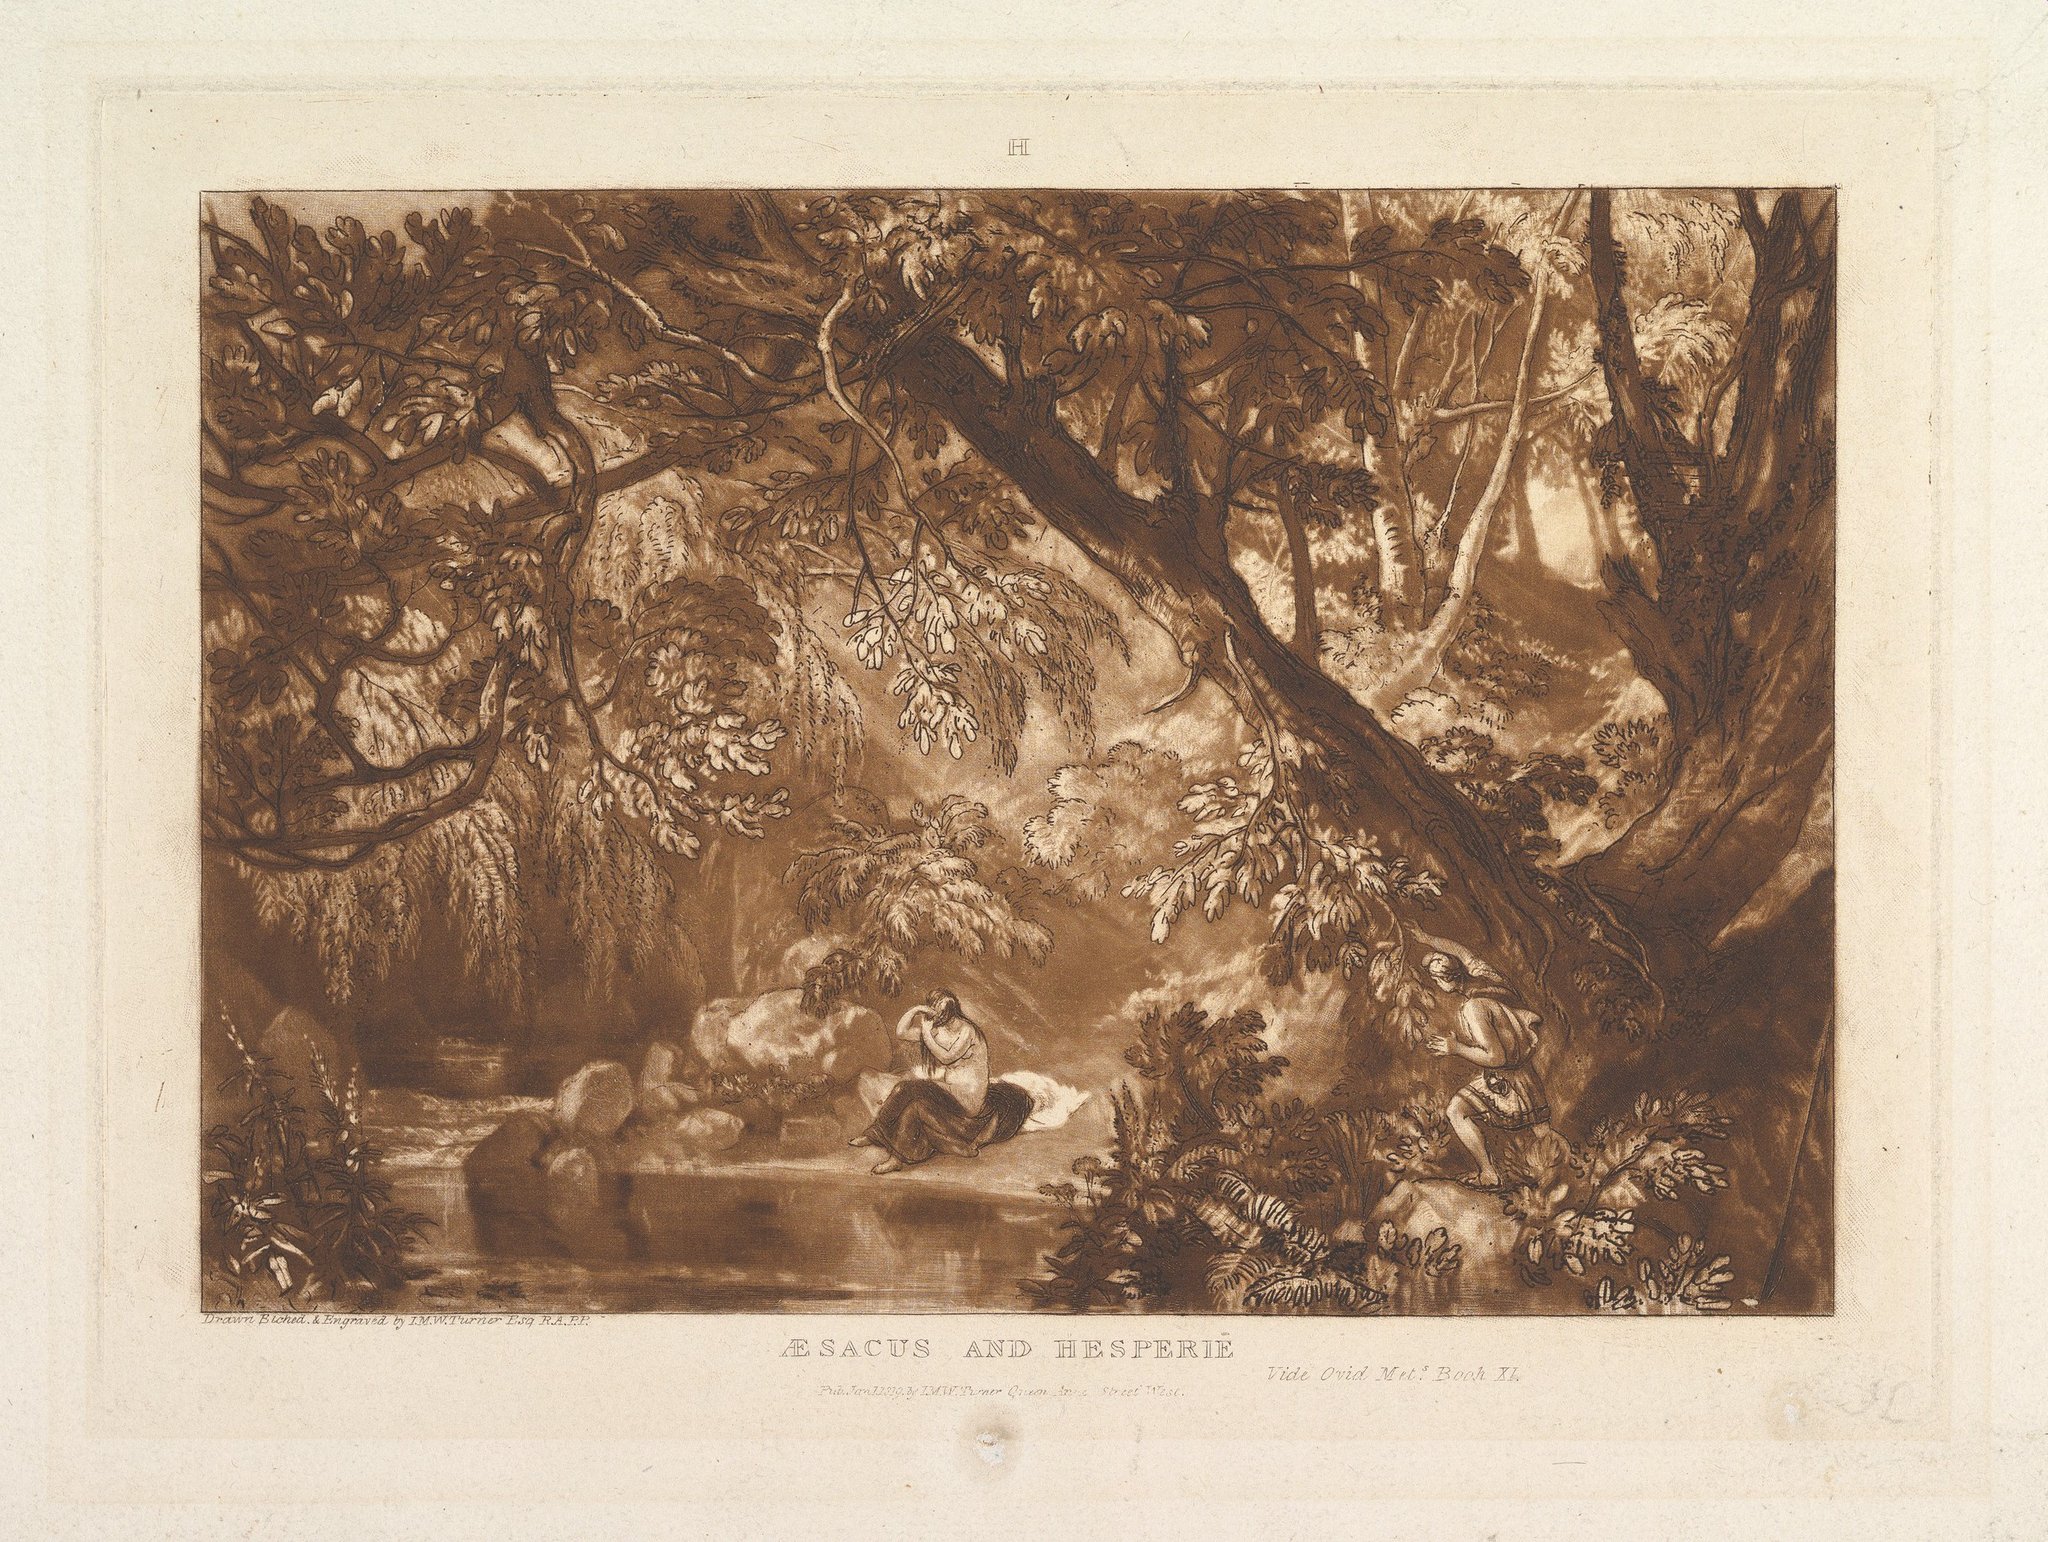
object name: print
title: Aesacus and Hesperie, Vide Ovid Metamorphosis, Book XI, part XIII, plate 66 from "Liber Studiorum"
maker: joseph mallord william turner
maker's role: artist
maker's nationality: british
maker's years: 1775-1851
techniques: etching, mezzotint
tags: nymphs,forests